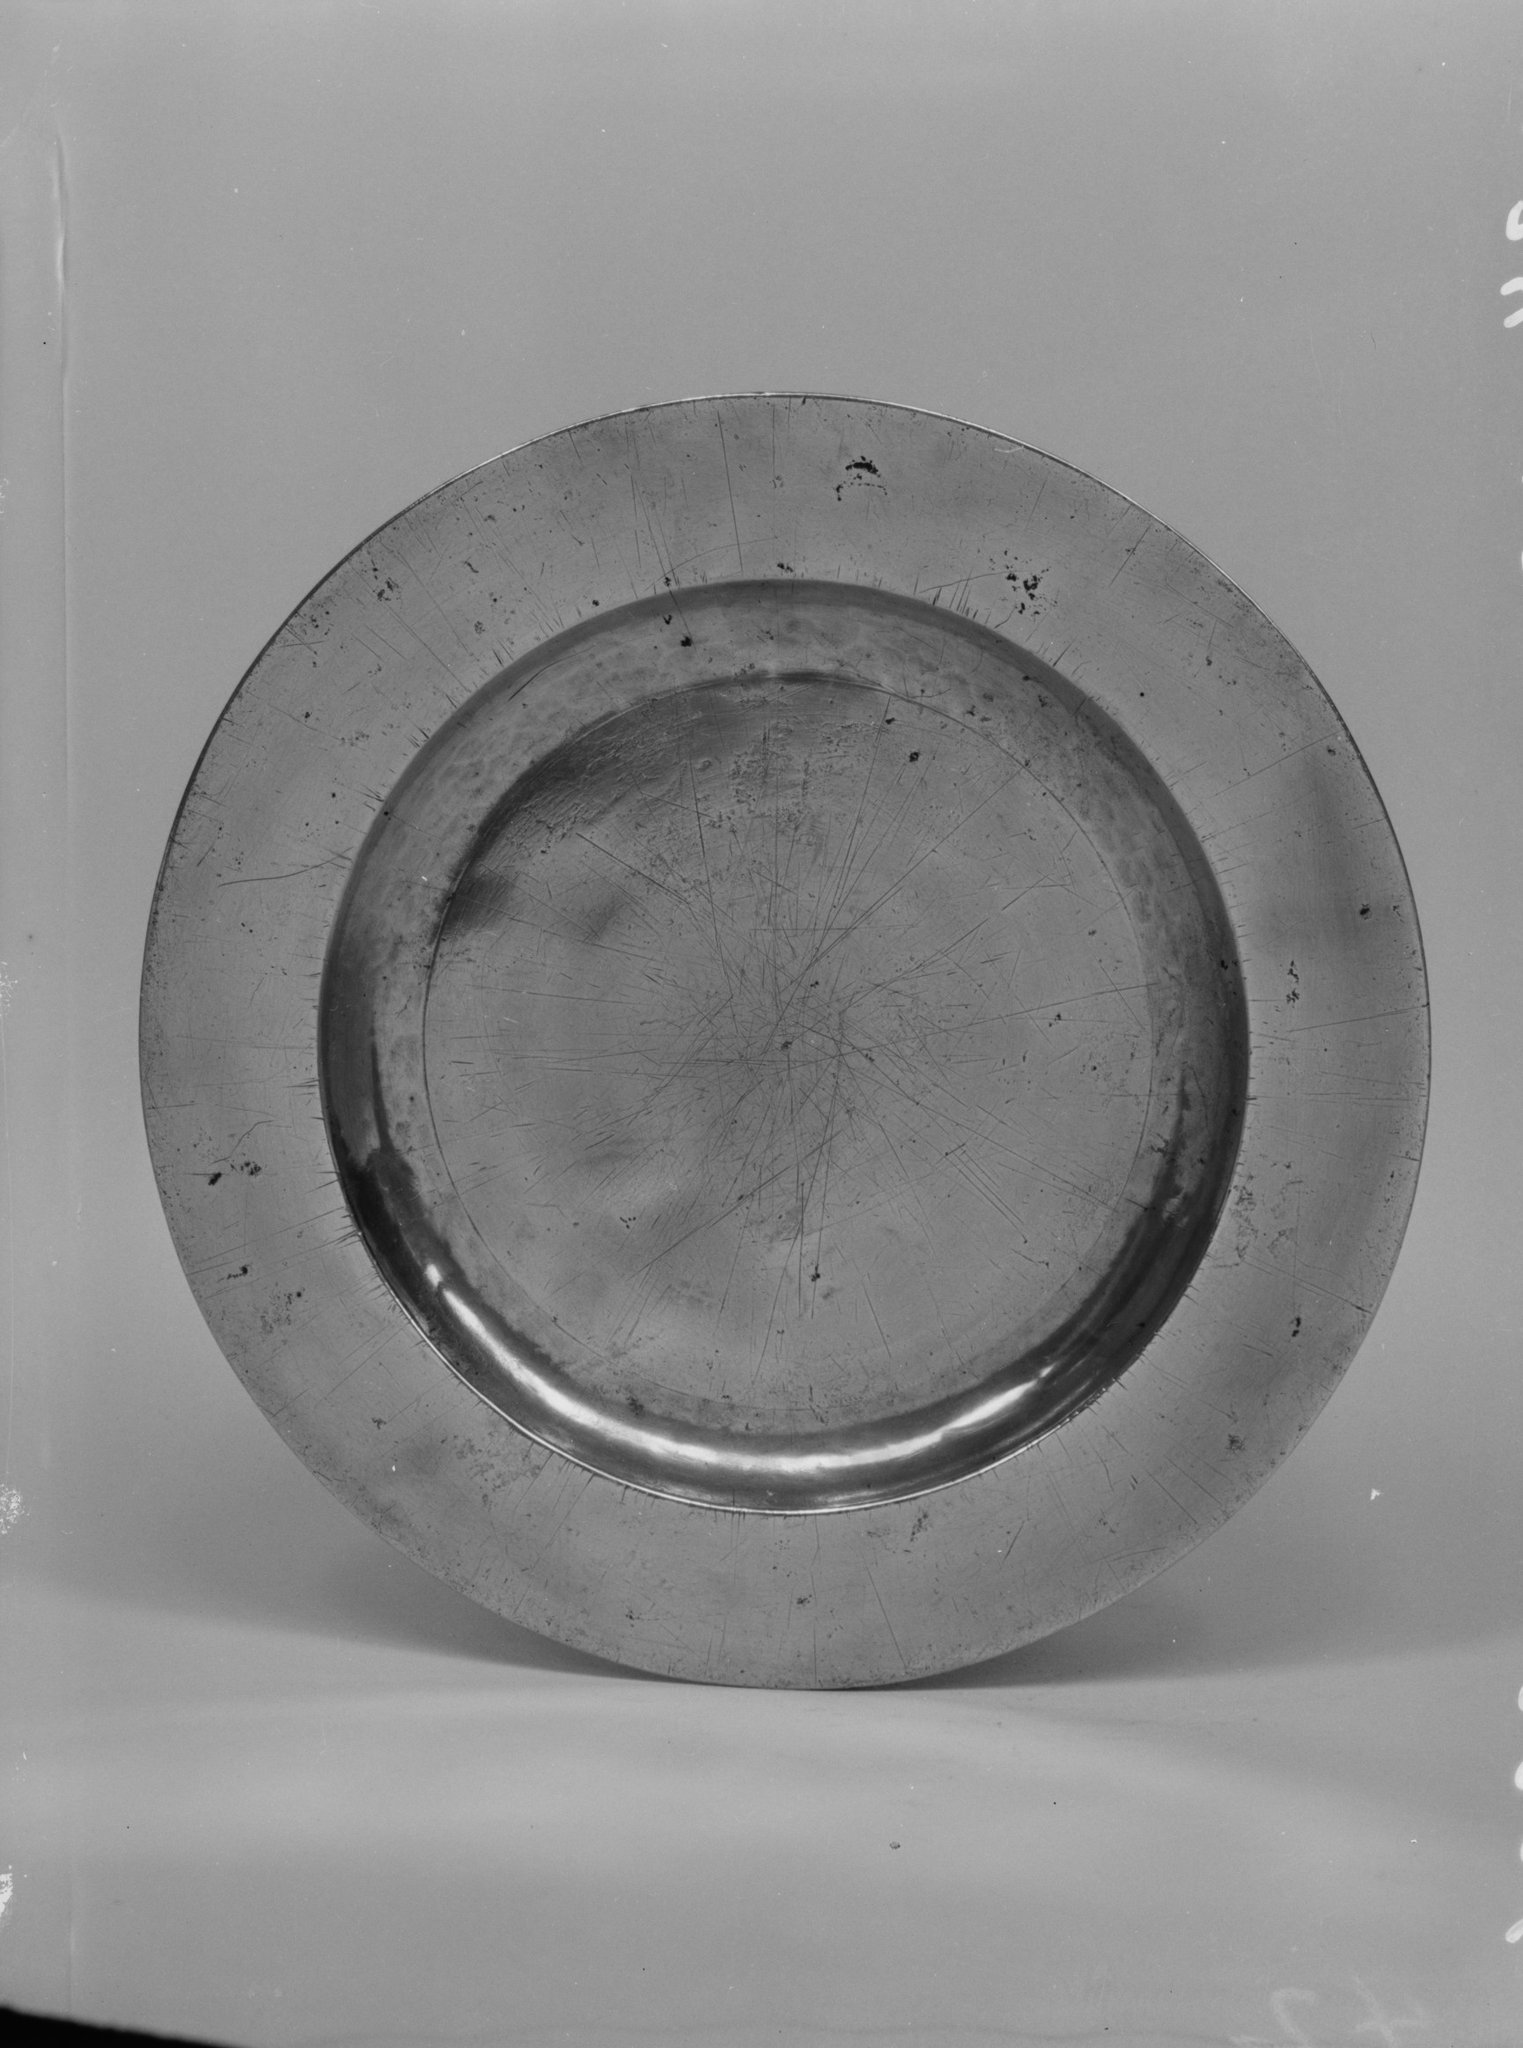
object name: dish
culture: american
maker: joseph danforth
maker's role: maker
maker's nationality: american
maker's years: 1758-1788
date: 1780-1788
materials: pewter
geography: united states